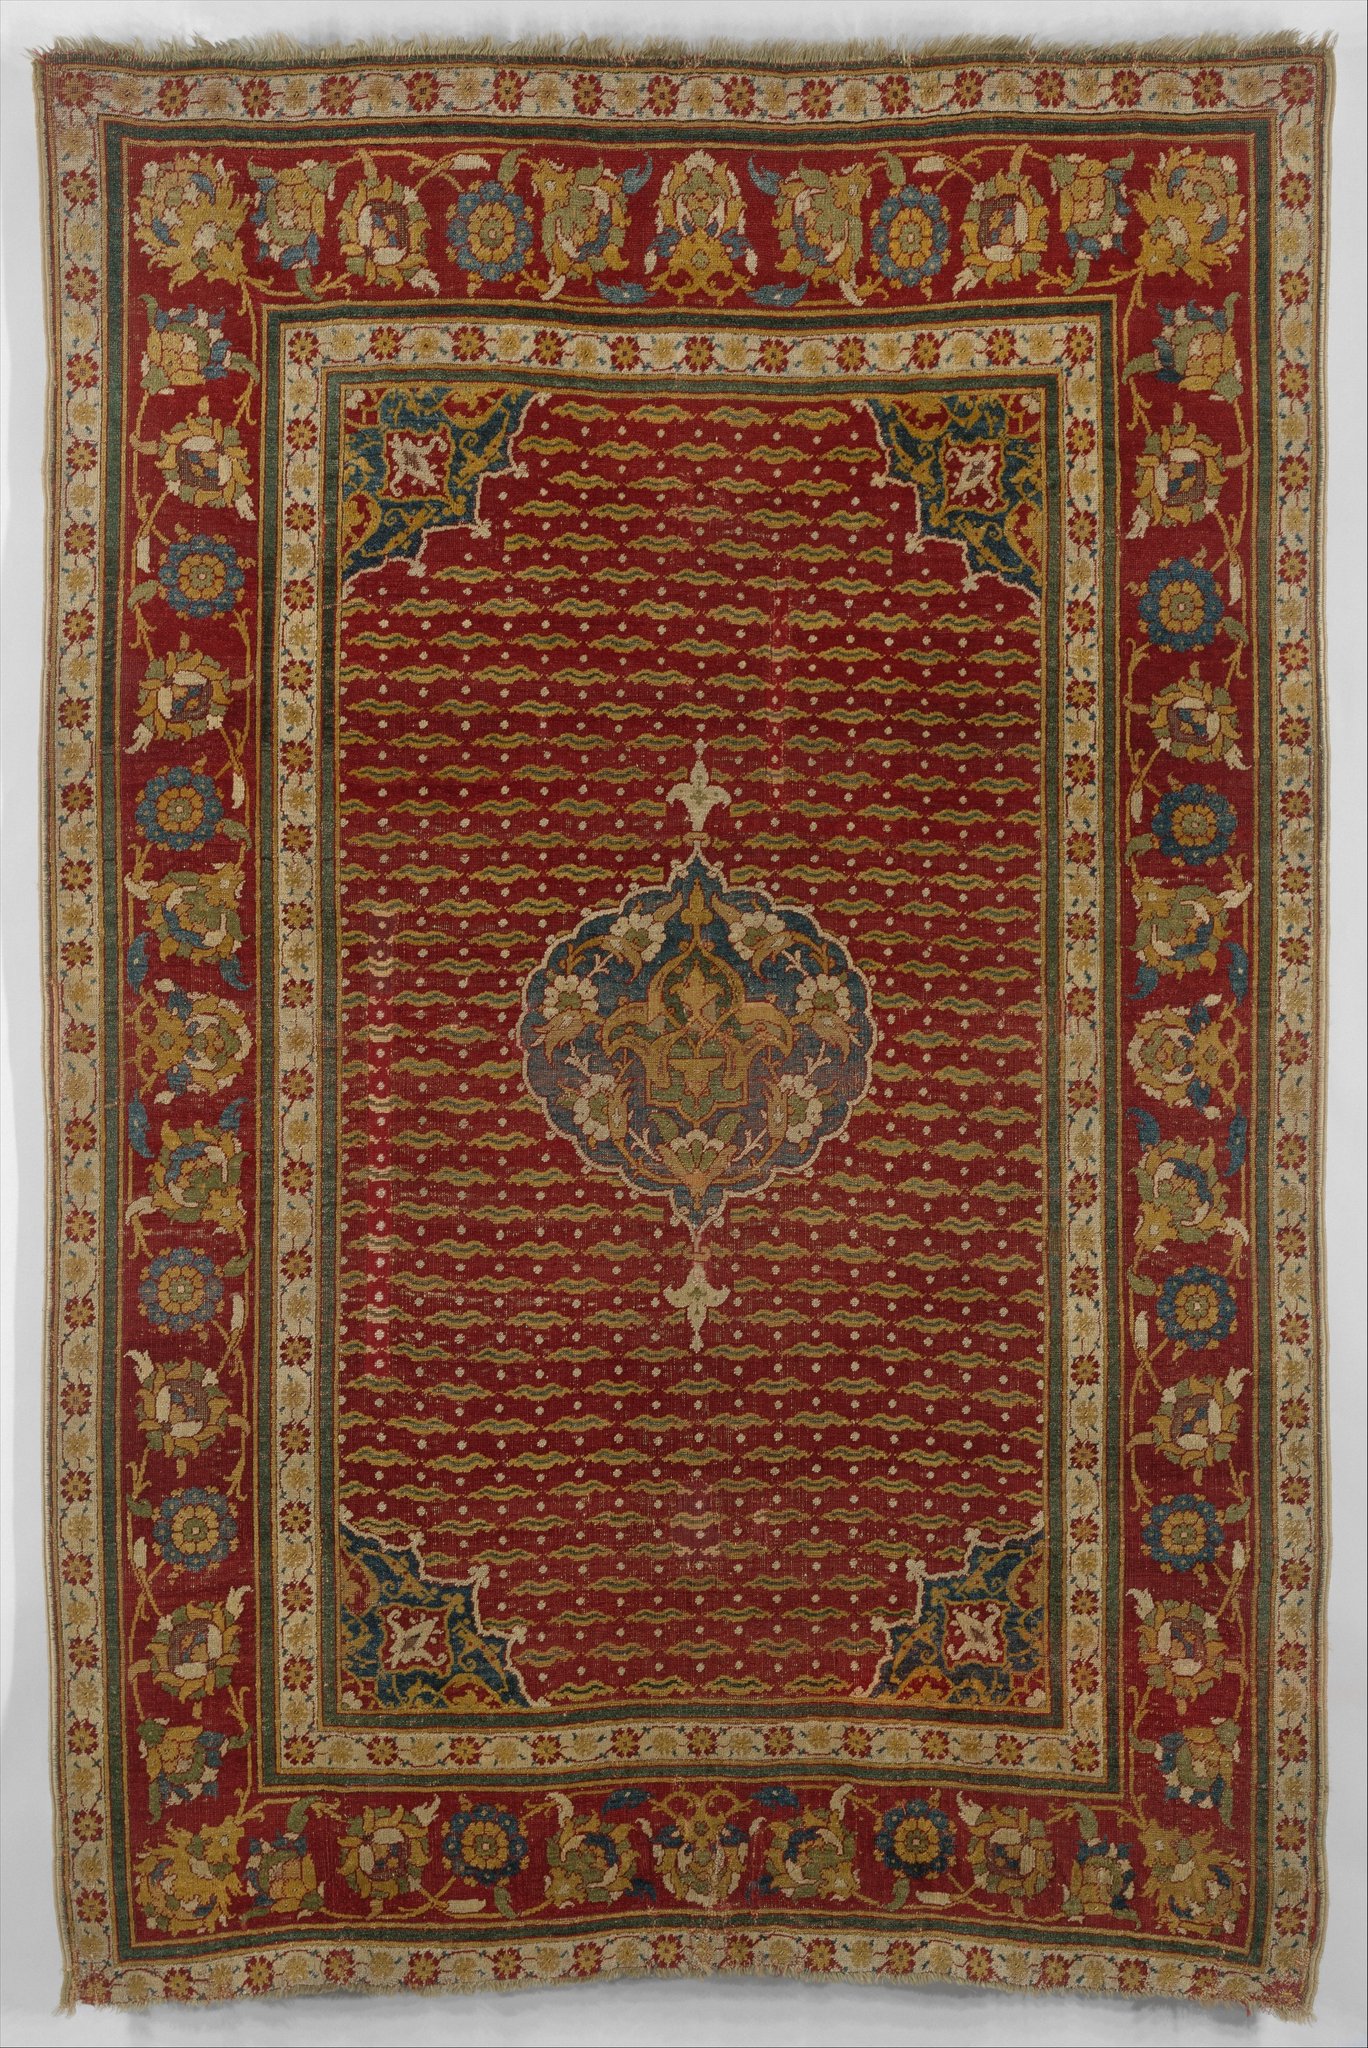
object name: carpet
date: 1550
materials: wool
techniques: asymmetrically knotted pile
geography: egypt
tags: flowers